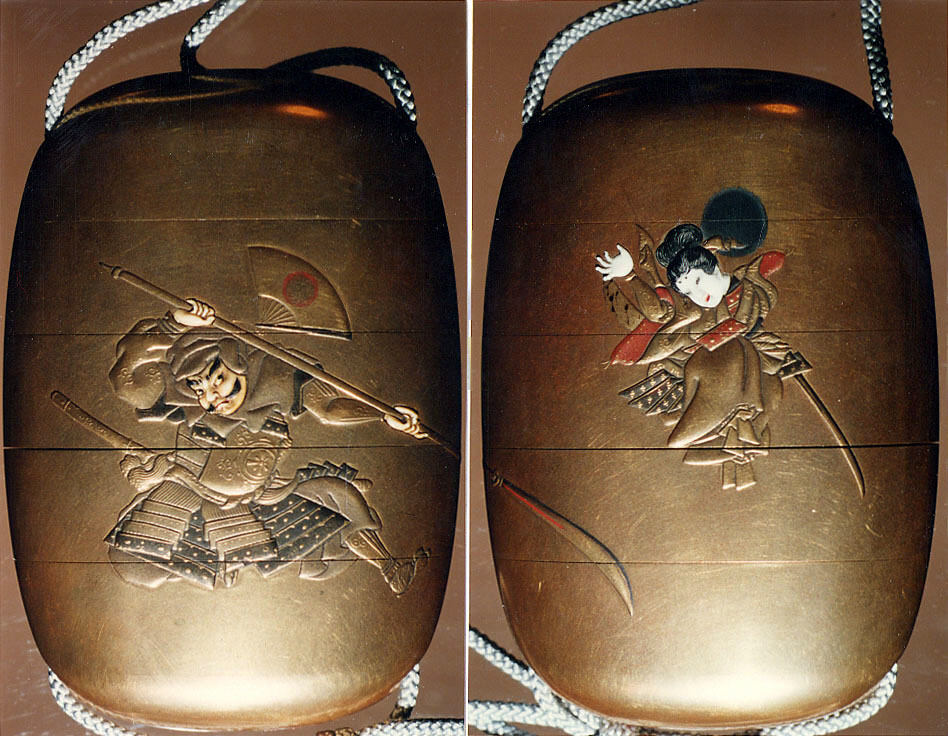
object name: inrō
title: Case (Inrō) with scene of Yoshitsune and Benkei on the Gojō Bridge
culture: japanese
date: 1801-1900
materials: gold, ivory, lacquer, silver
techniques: fundame, hiramakie, inlay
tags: weapons,men